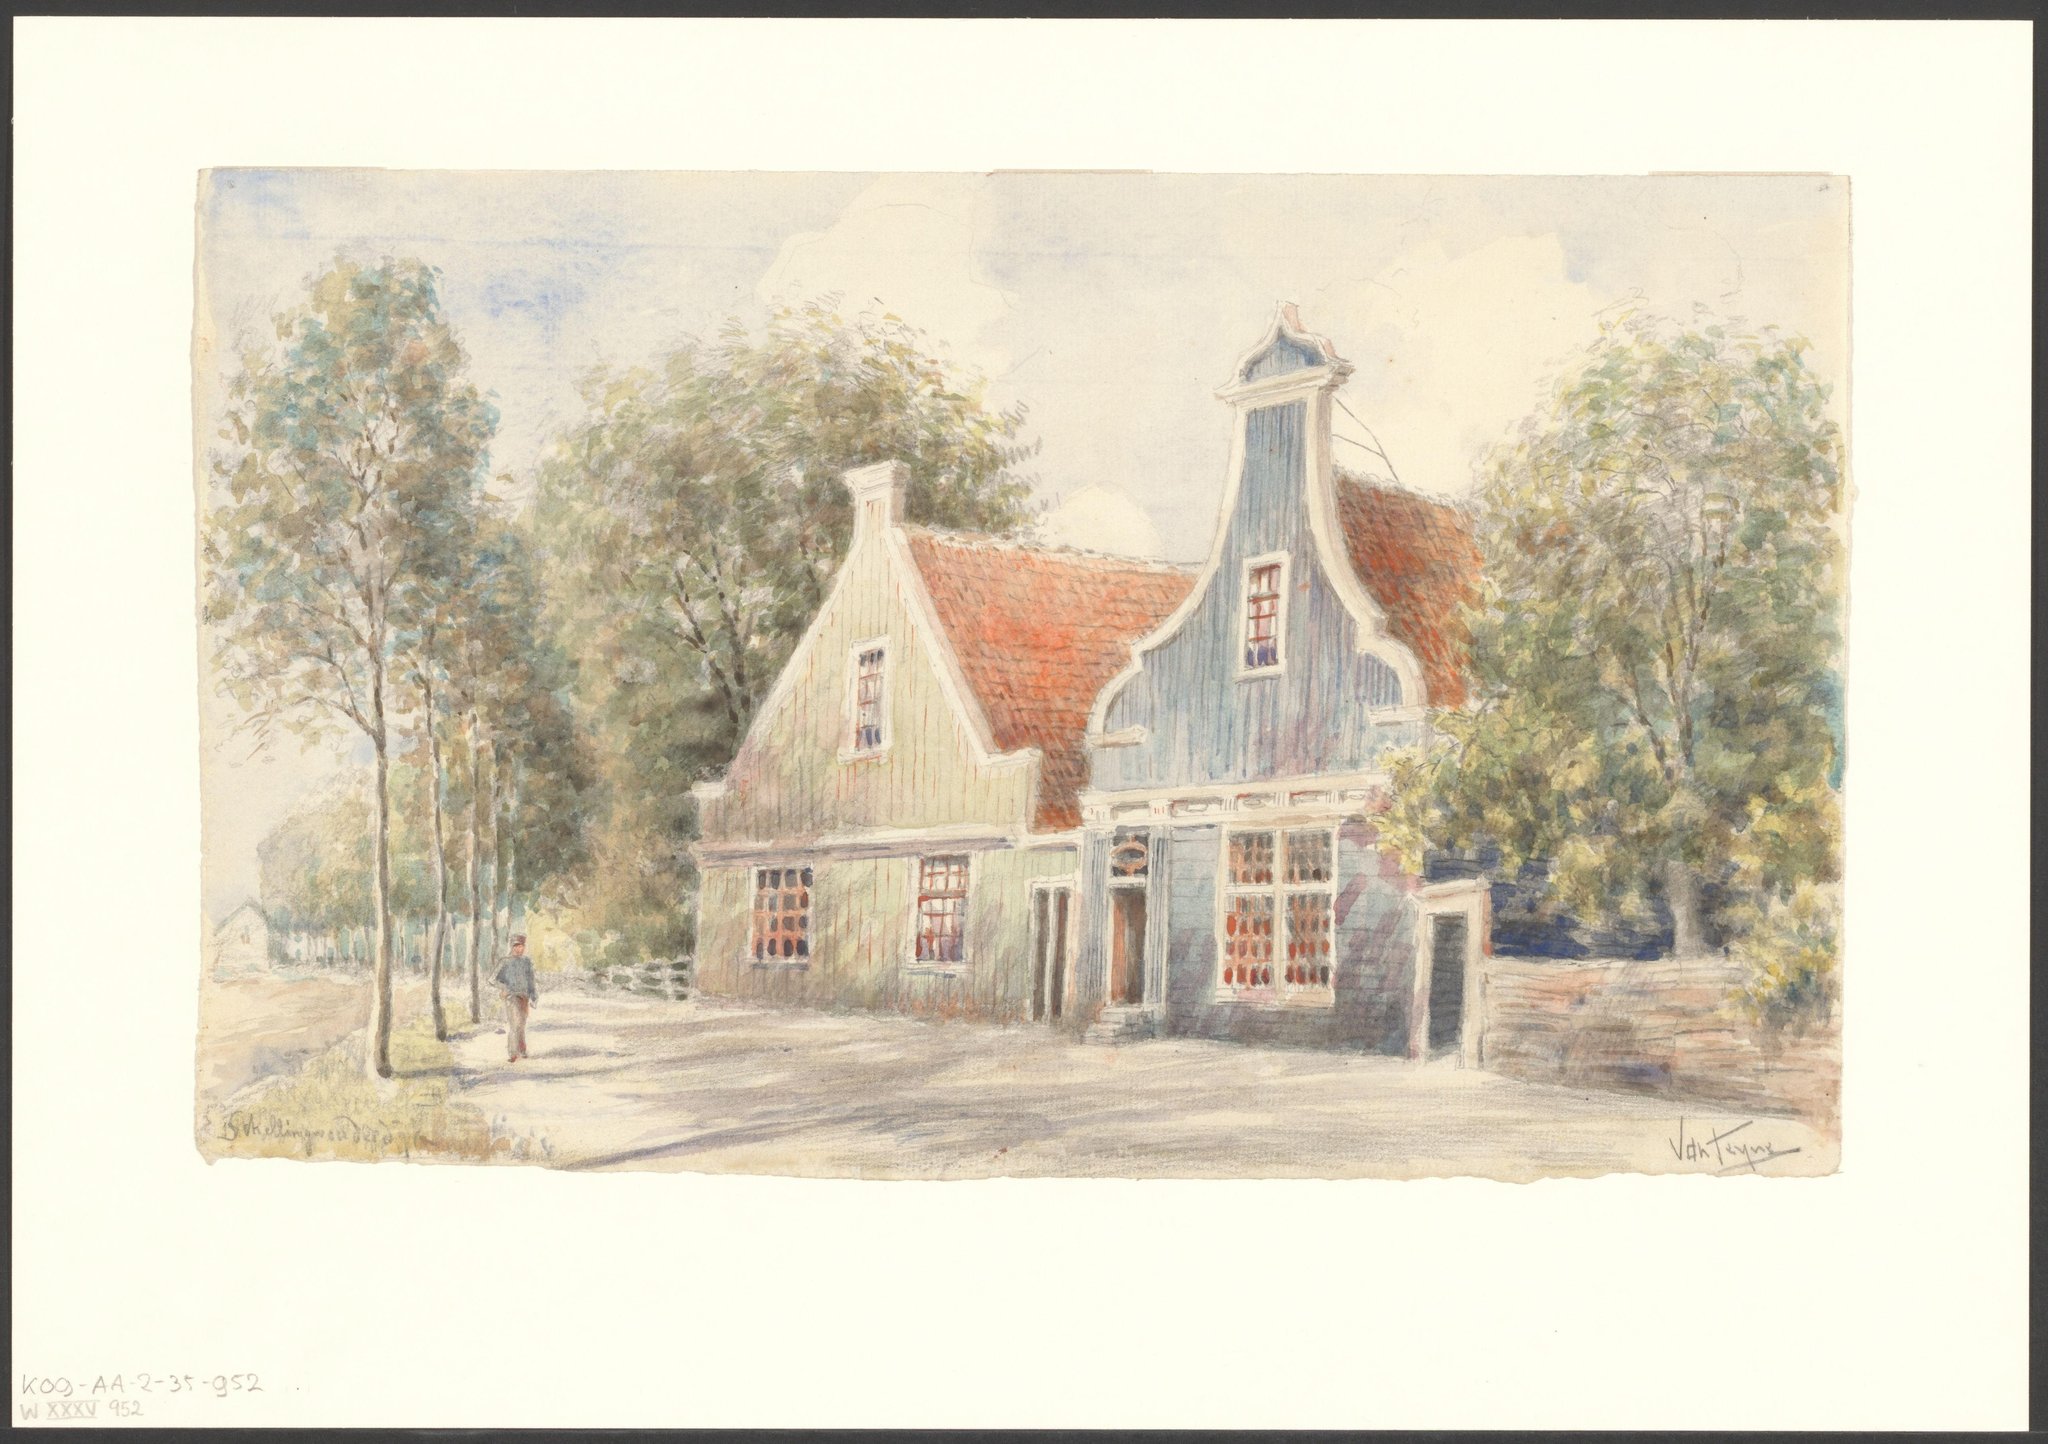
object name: drawing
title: Gezicht op de Schellingwouderdijk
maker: anthonie van teijn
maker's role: draughtsman, painter, print maker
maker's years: 1863-1943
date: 1928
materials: paper, pencil, watercolor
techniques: brush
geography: amsterdam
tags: village, road, path, the usual house or row of houses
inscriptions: inscription: ‘Schelling woude / No 357/357a en 359 -1928 -’, inscription: ‘Schellingwouderdijk’, collector's mark: Lugt 800a, signature: ‘VanTeyne’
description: Tekening binnen de Atlas Van Eck ingedeeld op wijknummer 35.